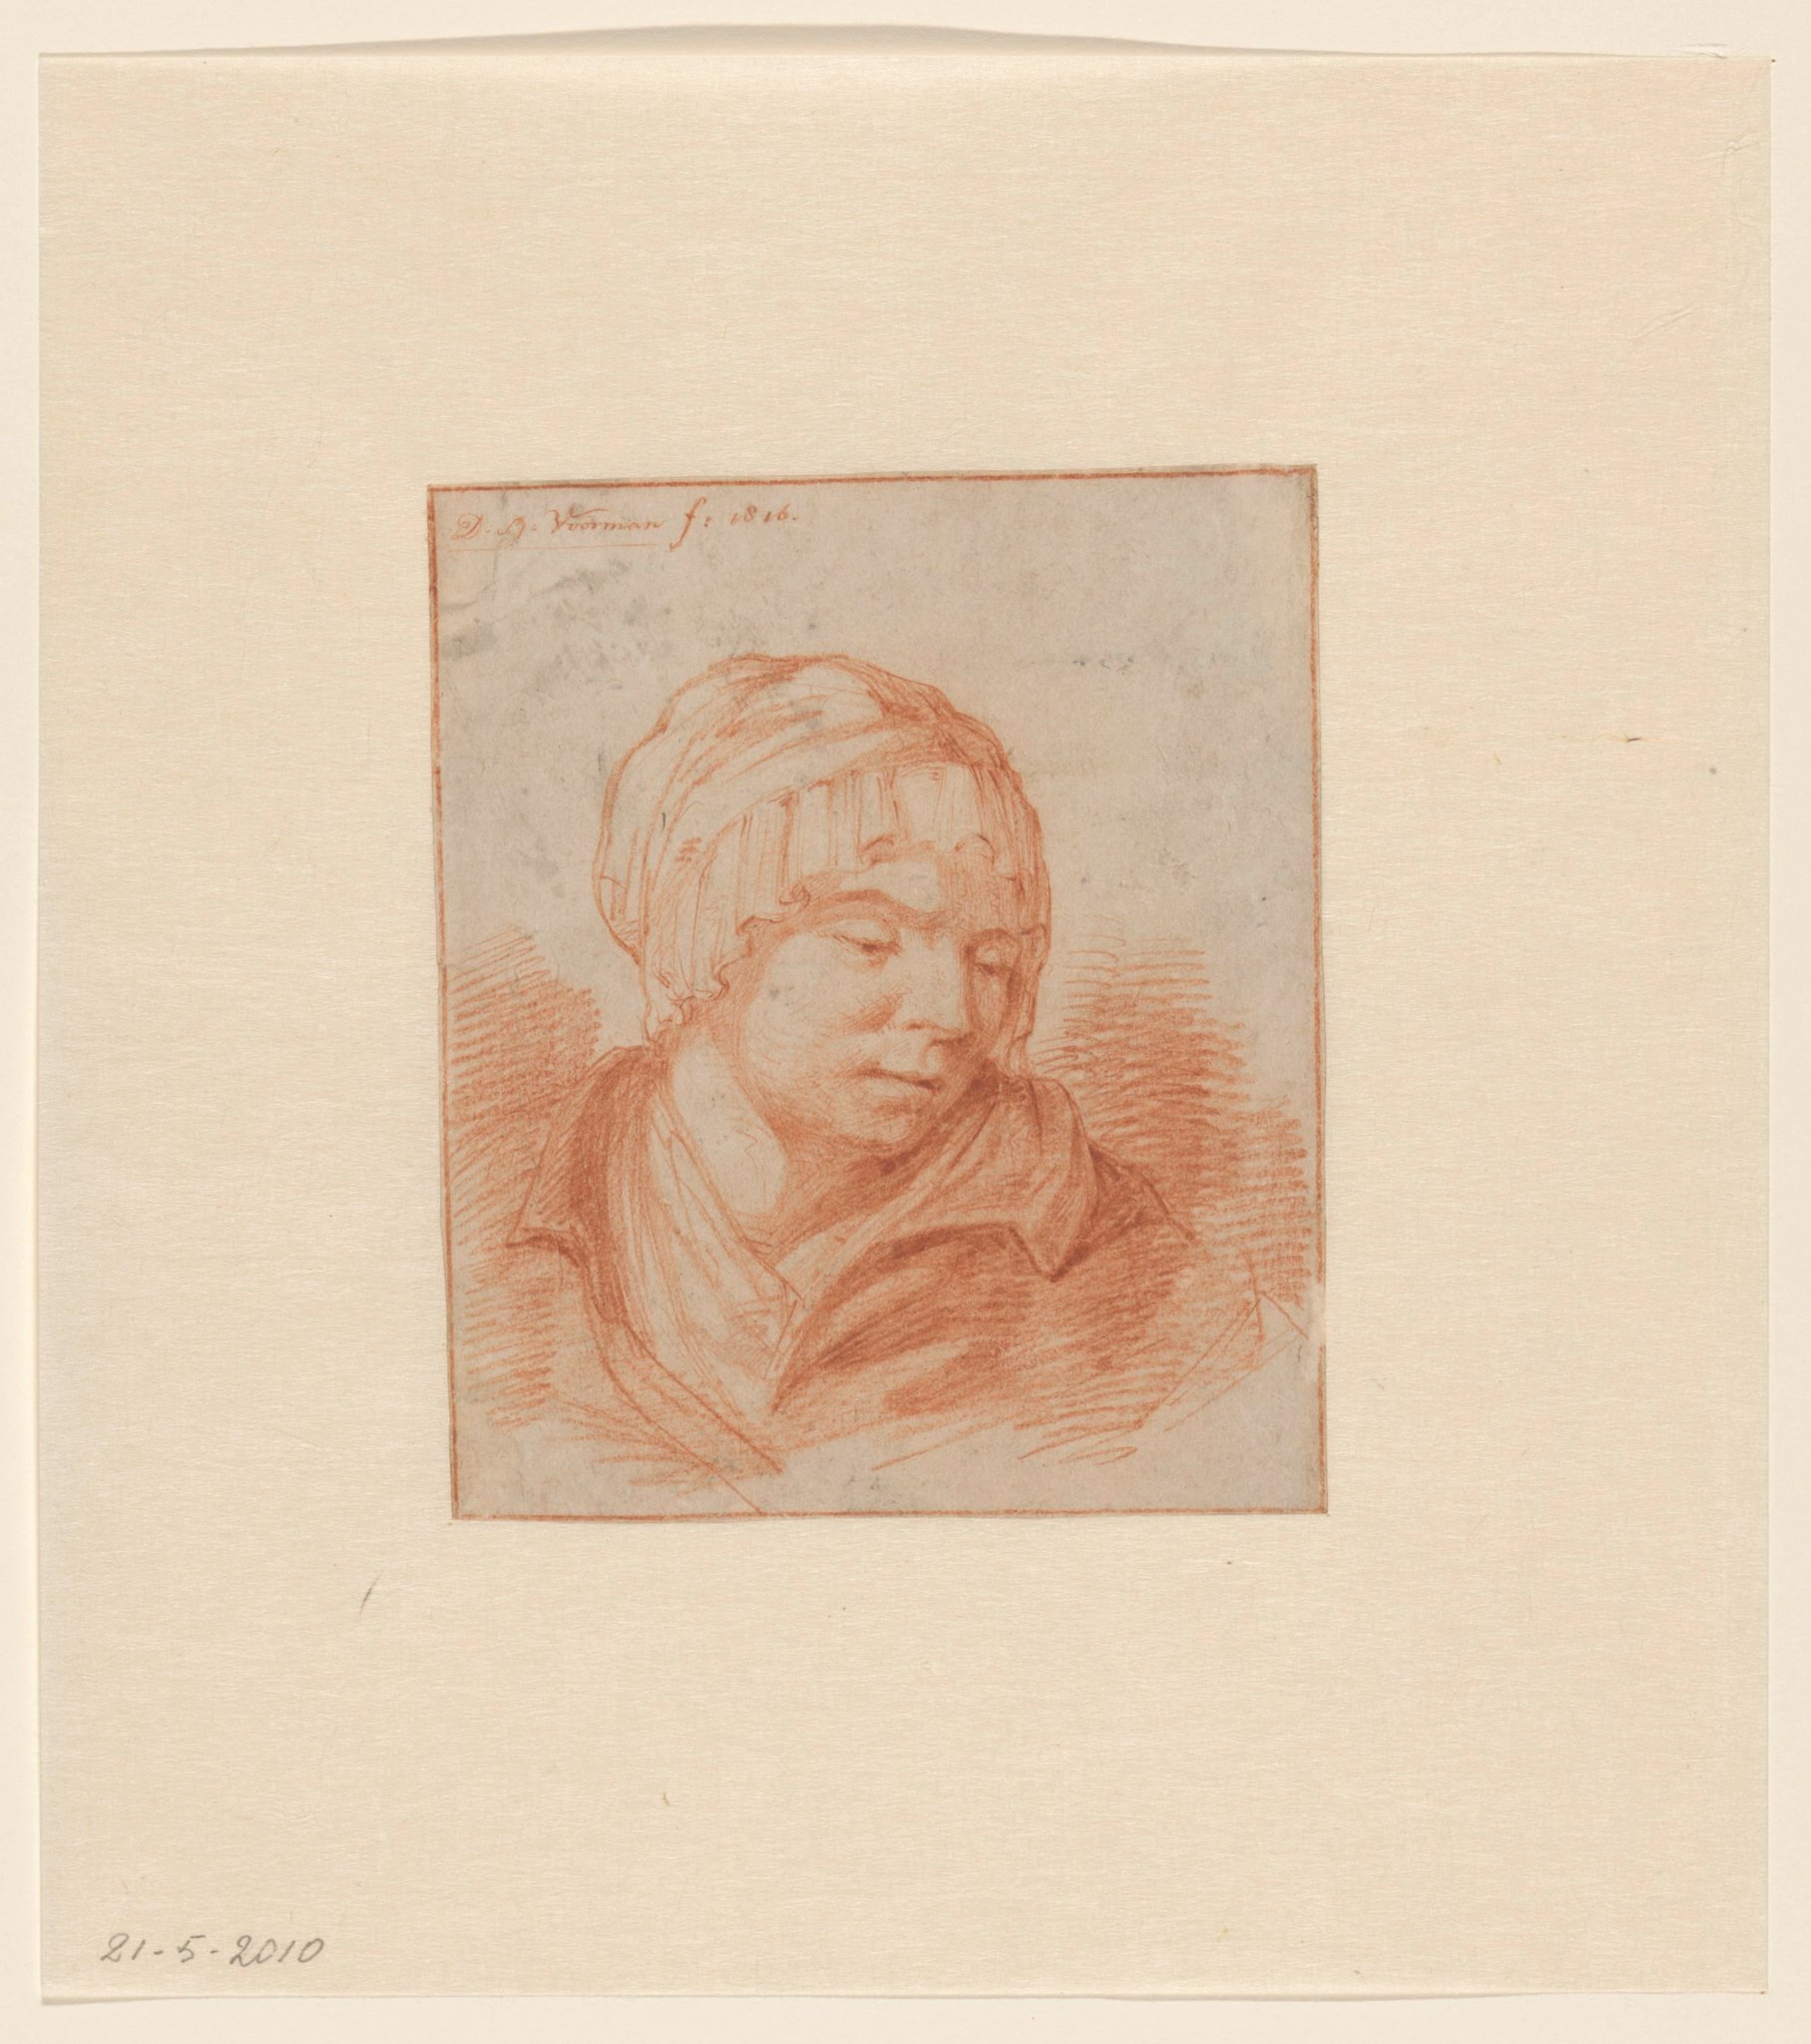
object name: drawing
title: Studie van een vrouwenhoofd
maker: daniël batavus voorman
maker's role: draughtsman, print maker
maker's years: 1795-1850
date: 1816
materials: chalk, paper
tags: head (human)